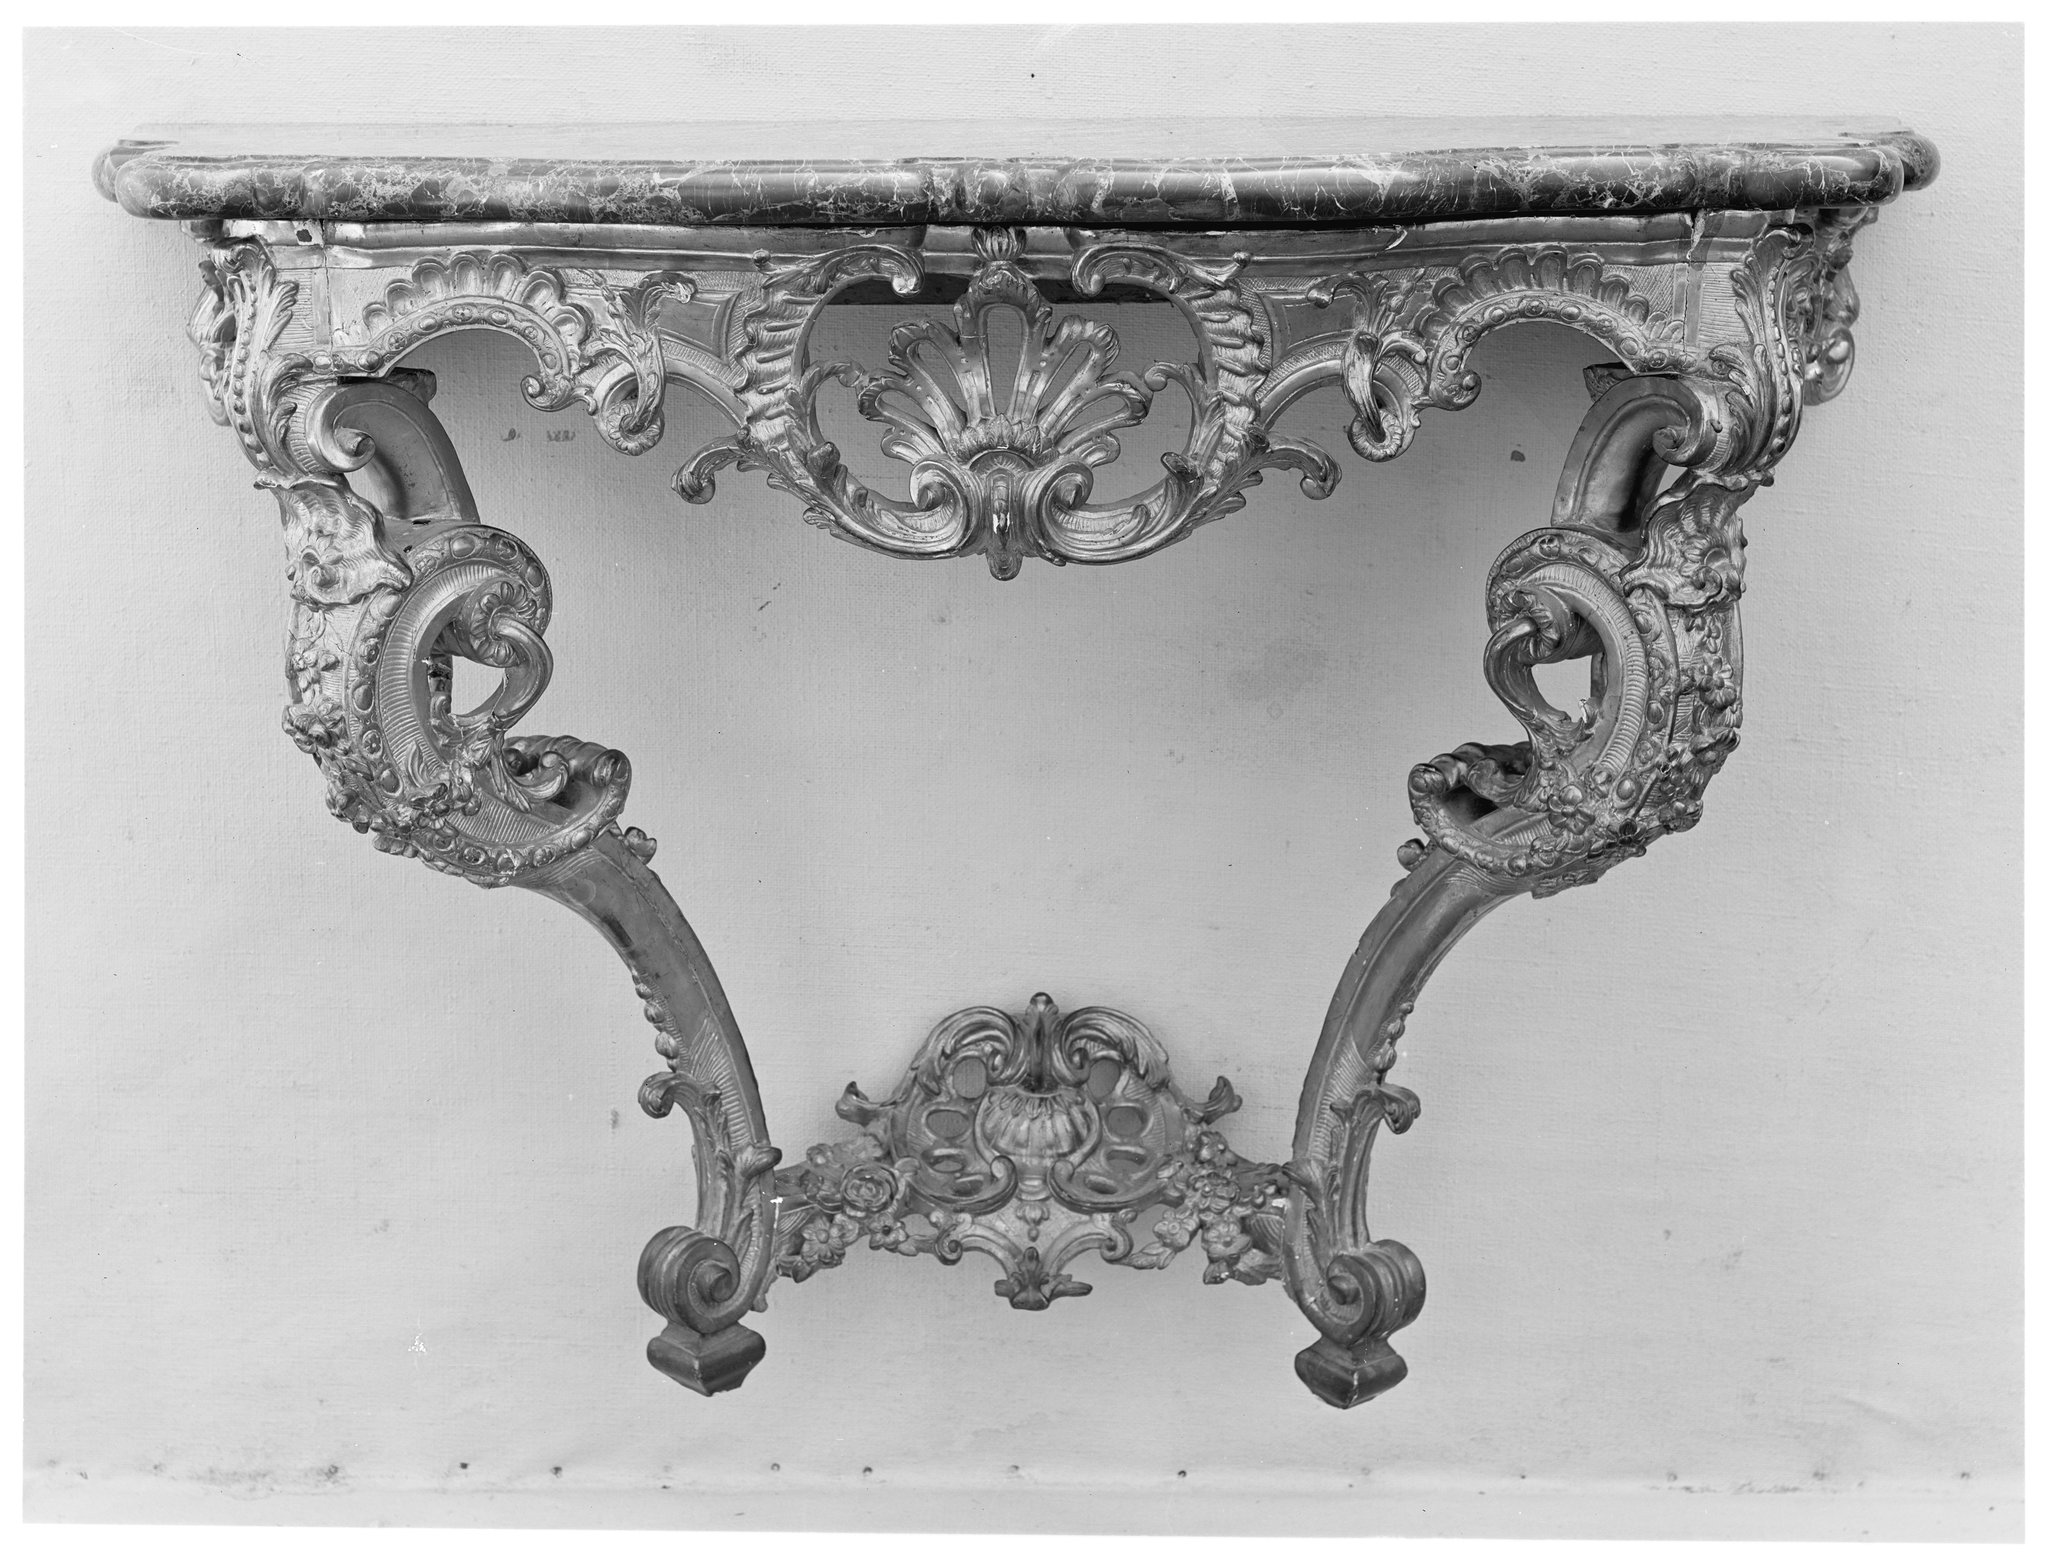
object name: console table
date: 1701-1725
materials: marble, wood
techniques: carving, gilding